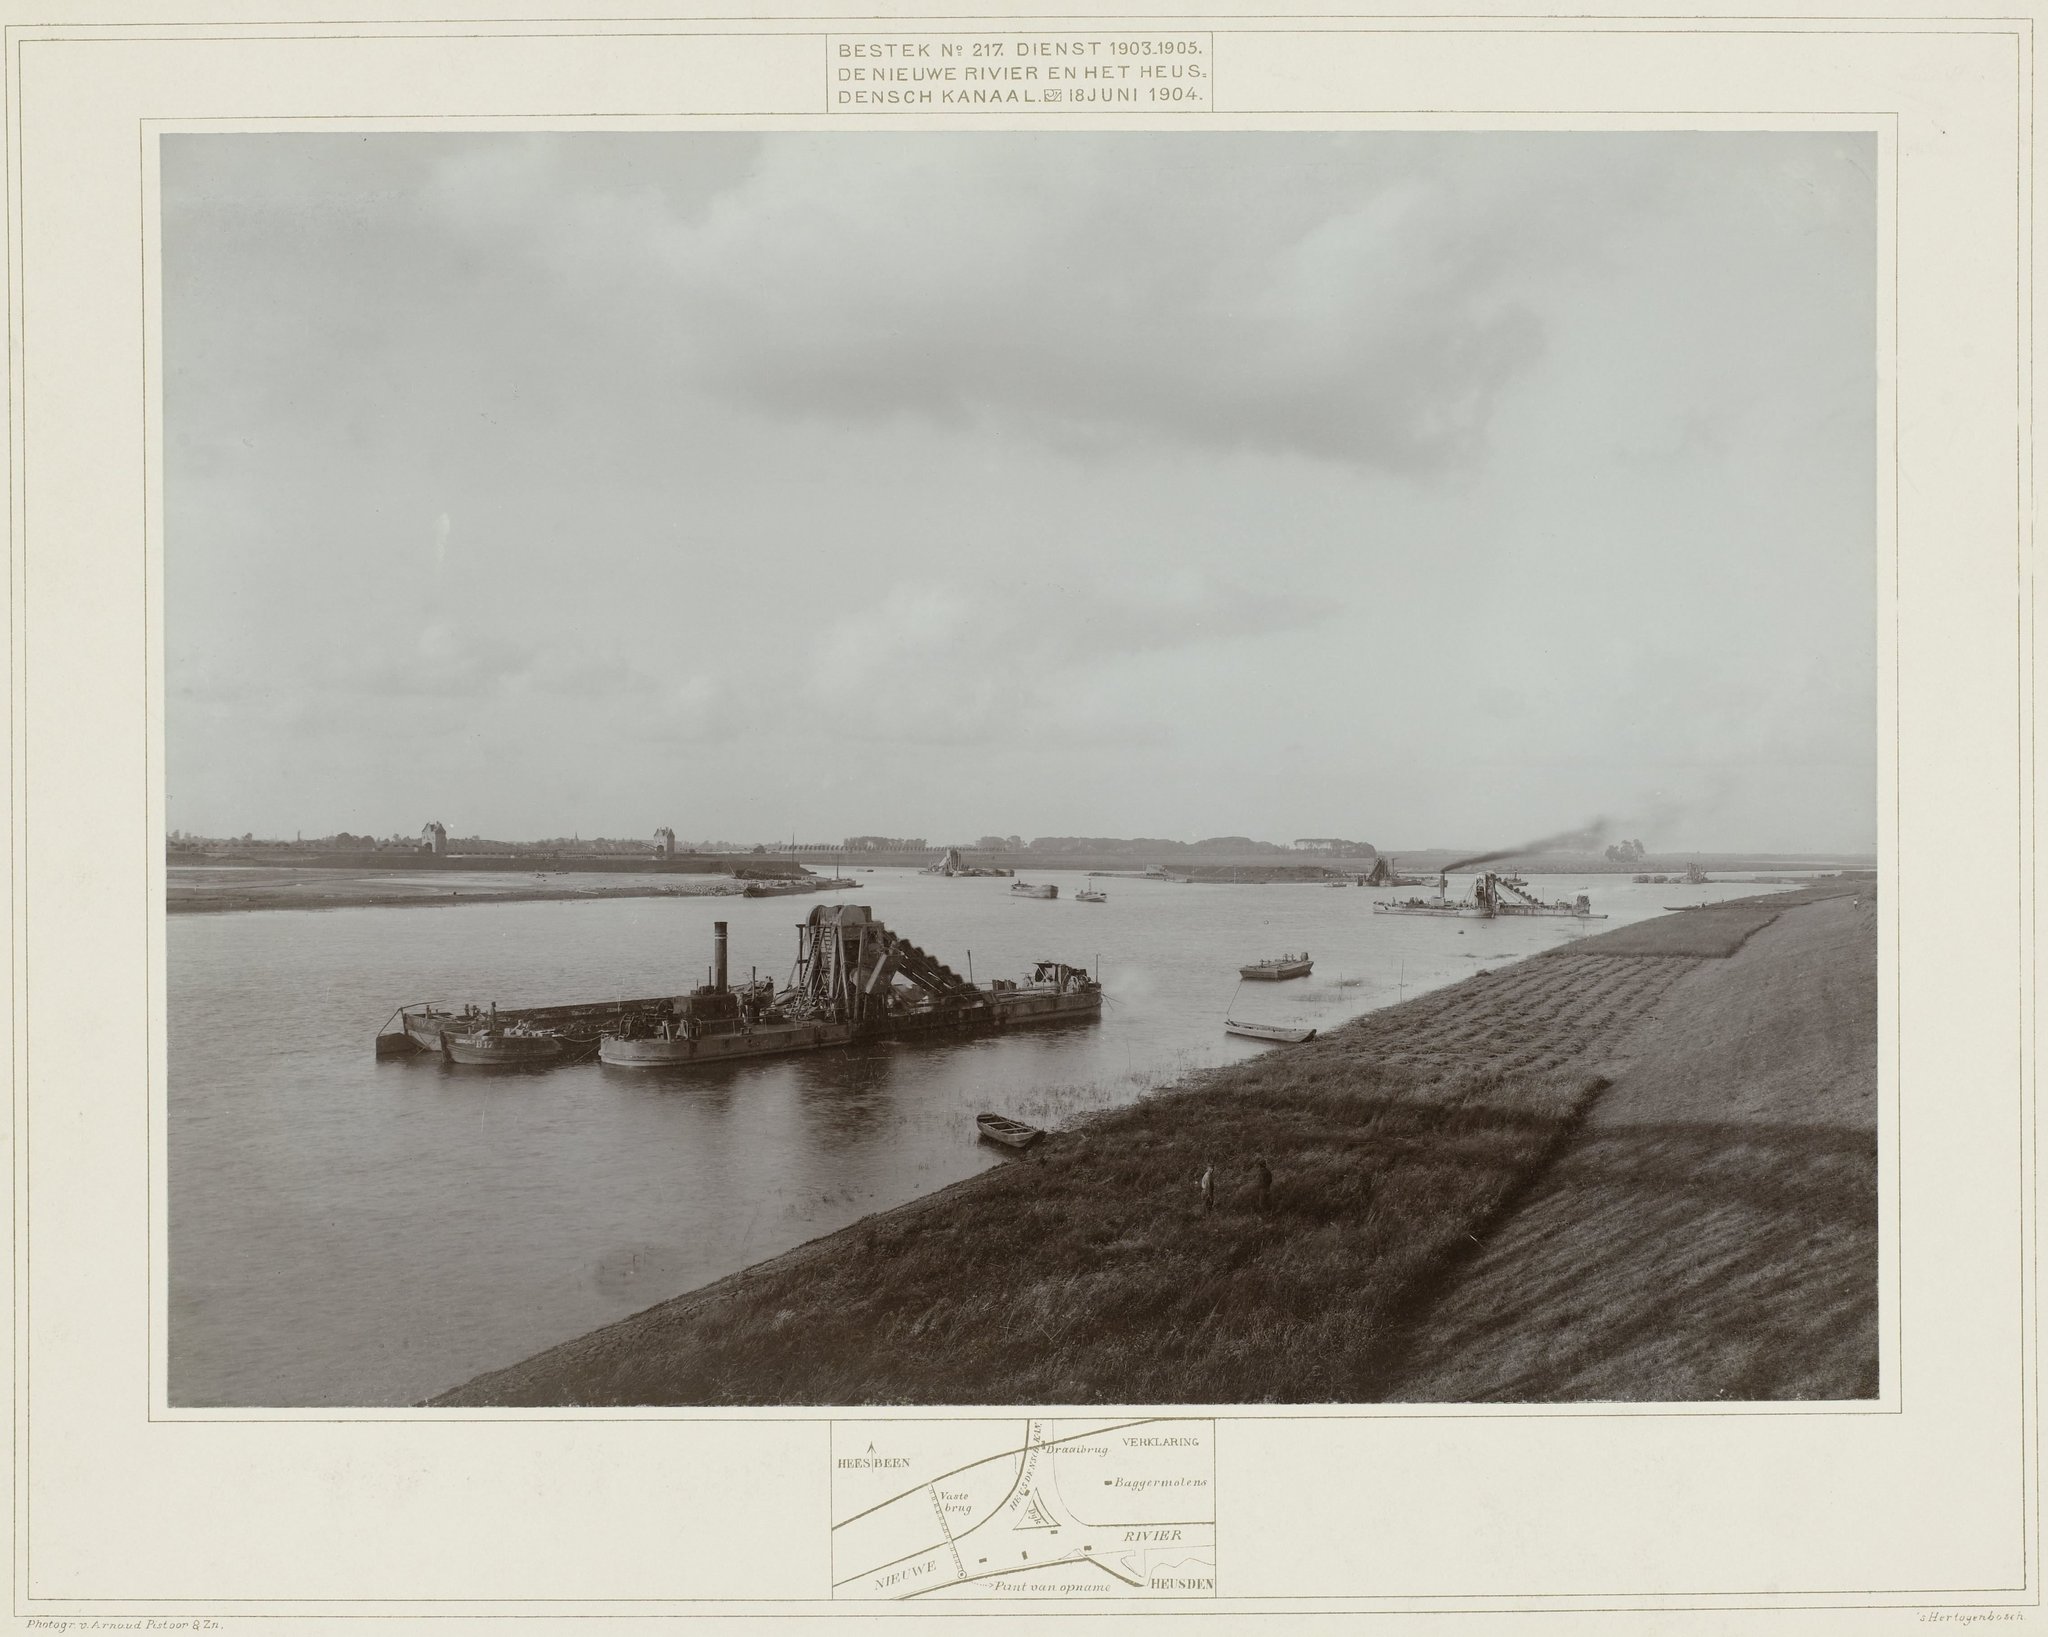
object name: photograph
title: Bestek nr. 217, dienst 1903, 1905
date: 1904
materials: cardboard, paper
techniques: photography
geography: den bosch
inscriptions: date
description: Foto op karton van waterbouwkundige werken (ten behoeve van de scheiding tussen maas en waal). Tekst boven de foto, onder de foto een situatiekaartje. Opschrift; b.: 'De Nieuwe rivier en het Heusdensch kanaal 18 juni, 1904. Gesigneerd en gedateerd.